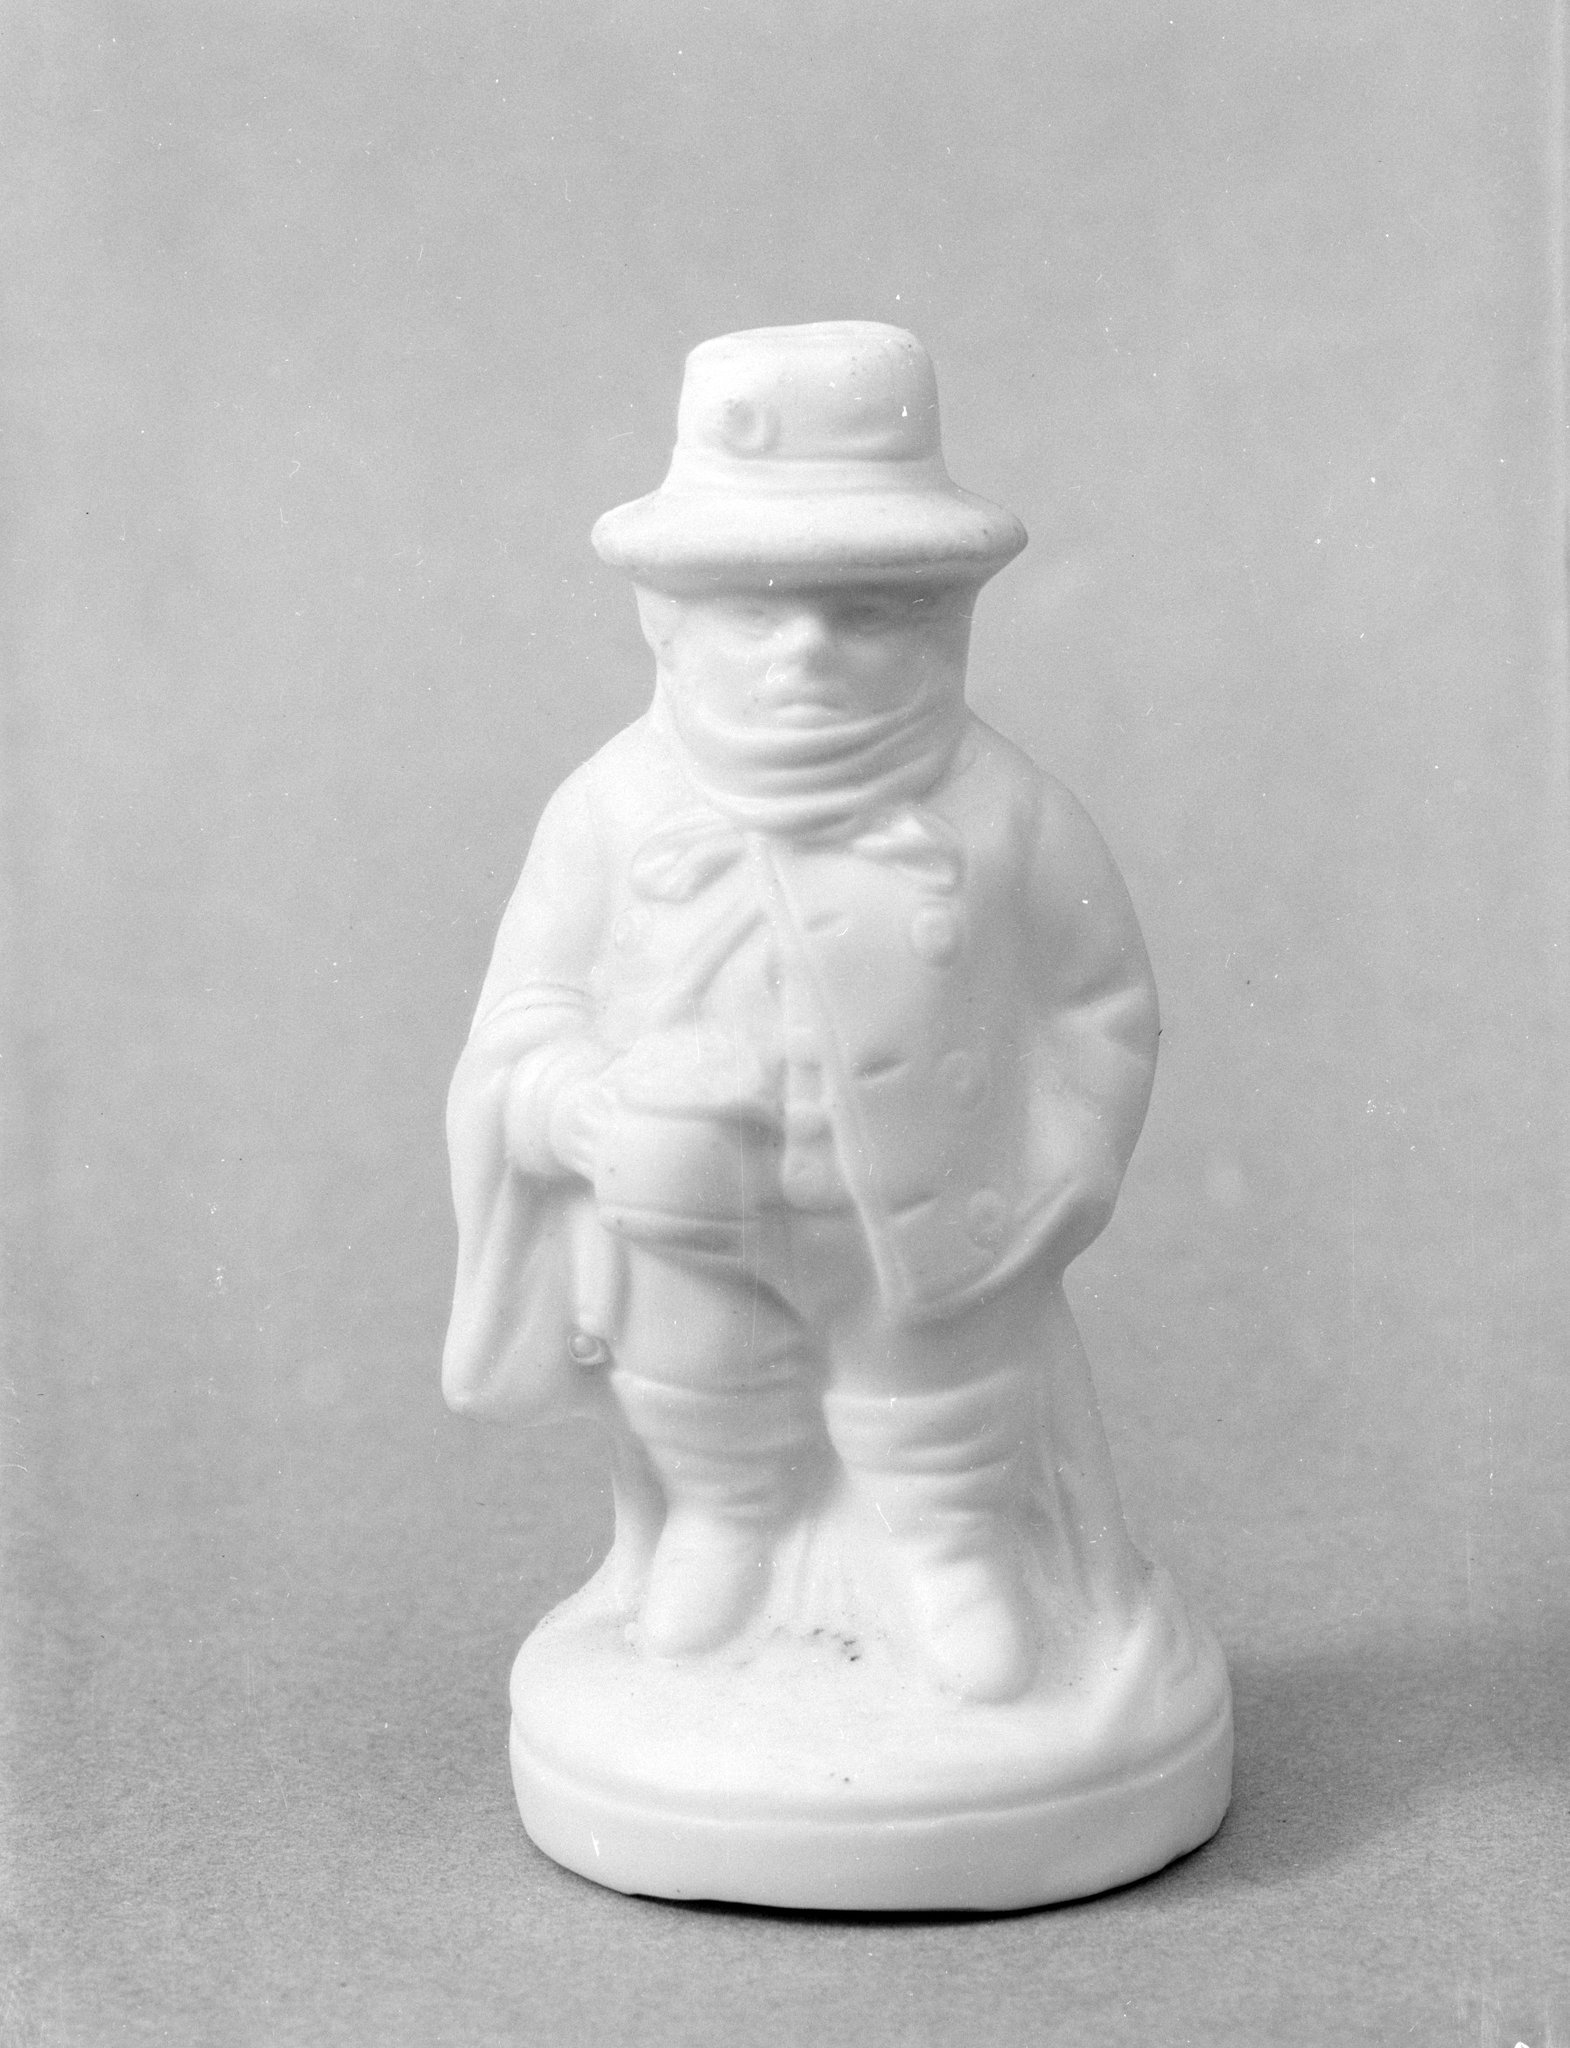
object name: figure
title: Figure of a Coachman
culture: american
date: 1830-1870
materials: porcelain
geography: united states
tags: men